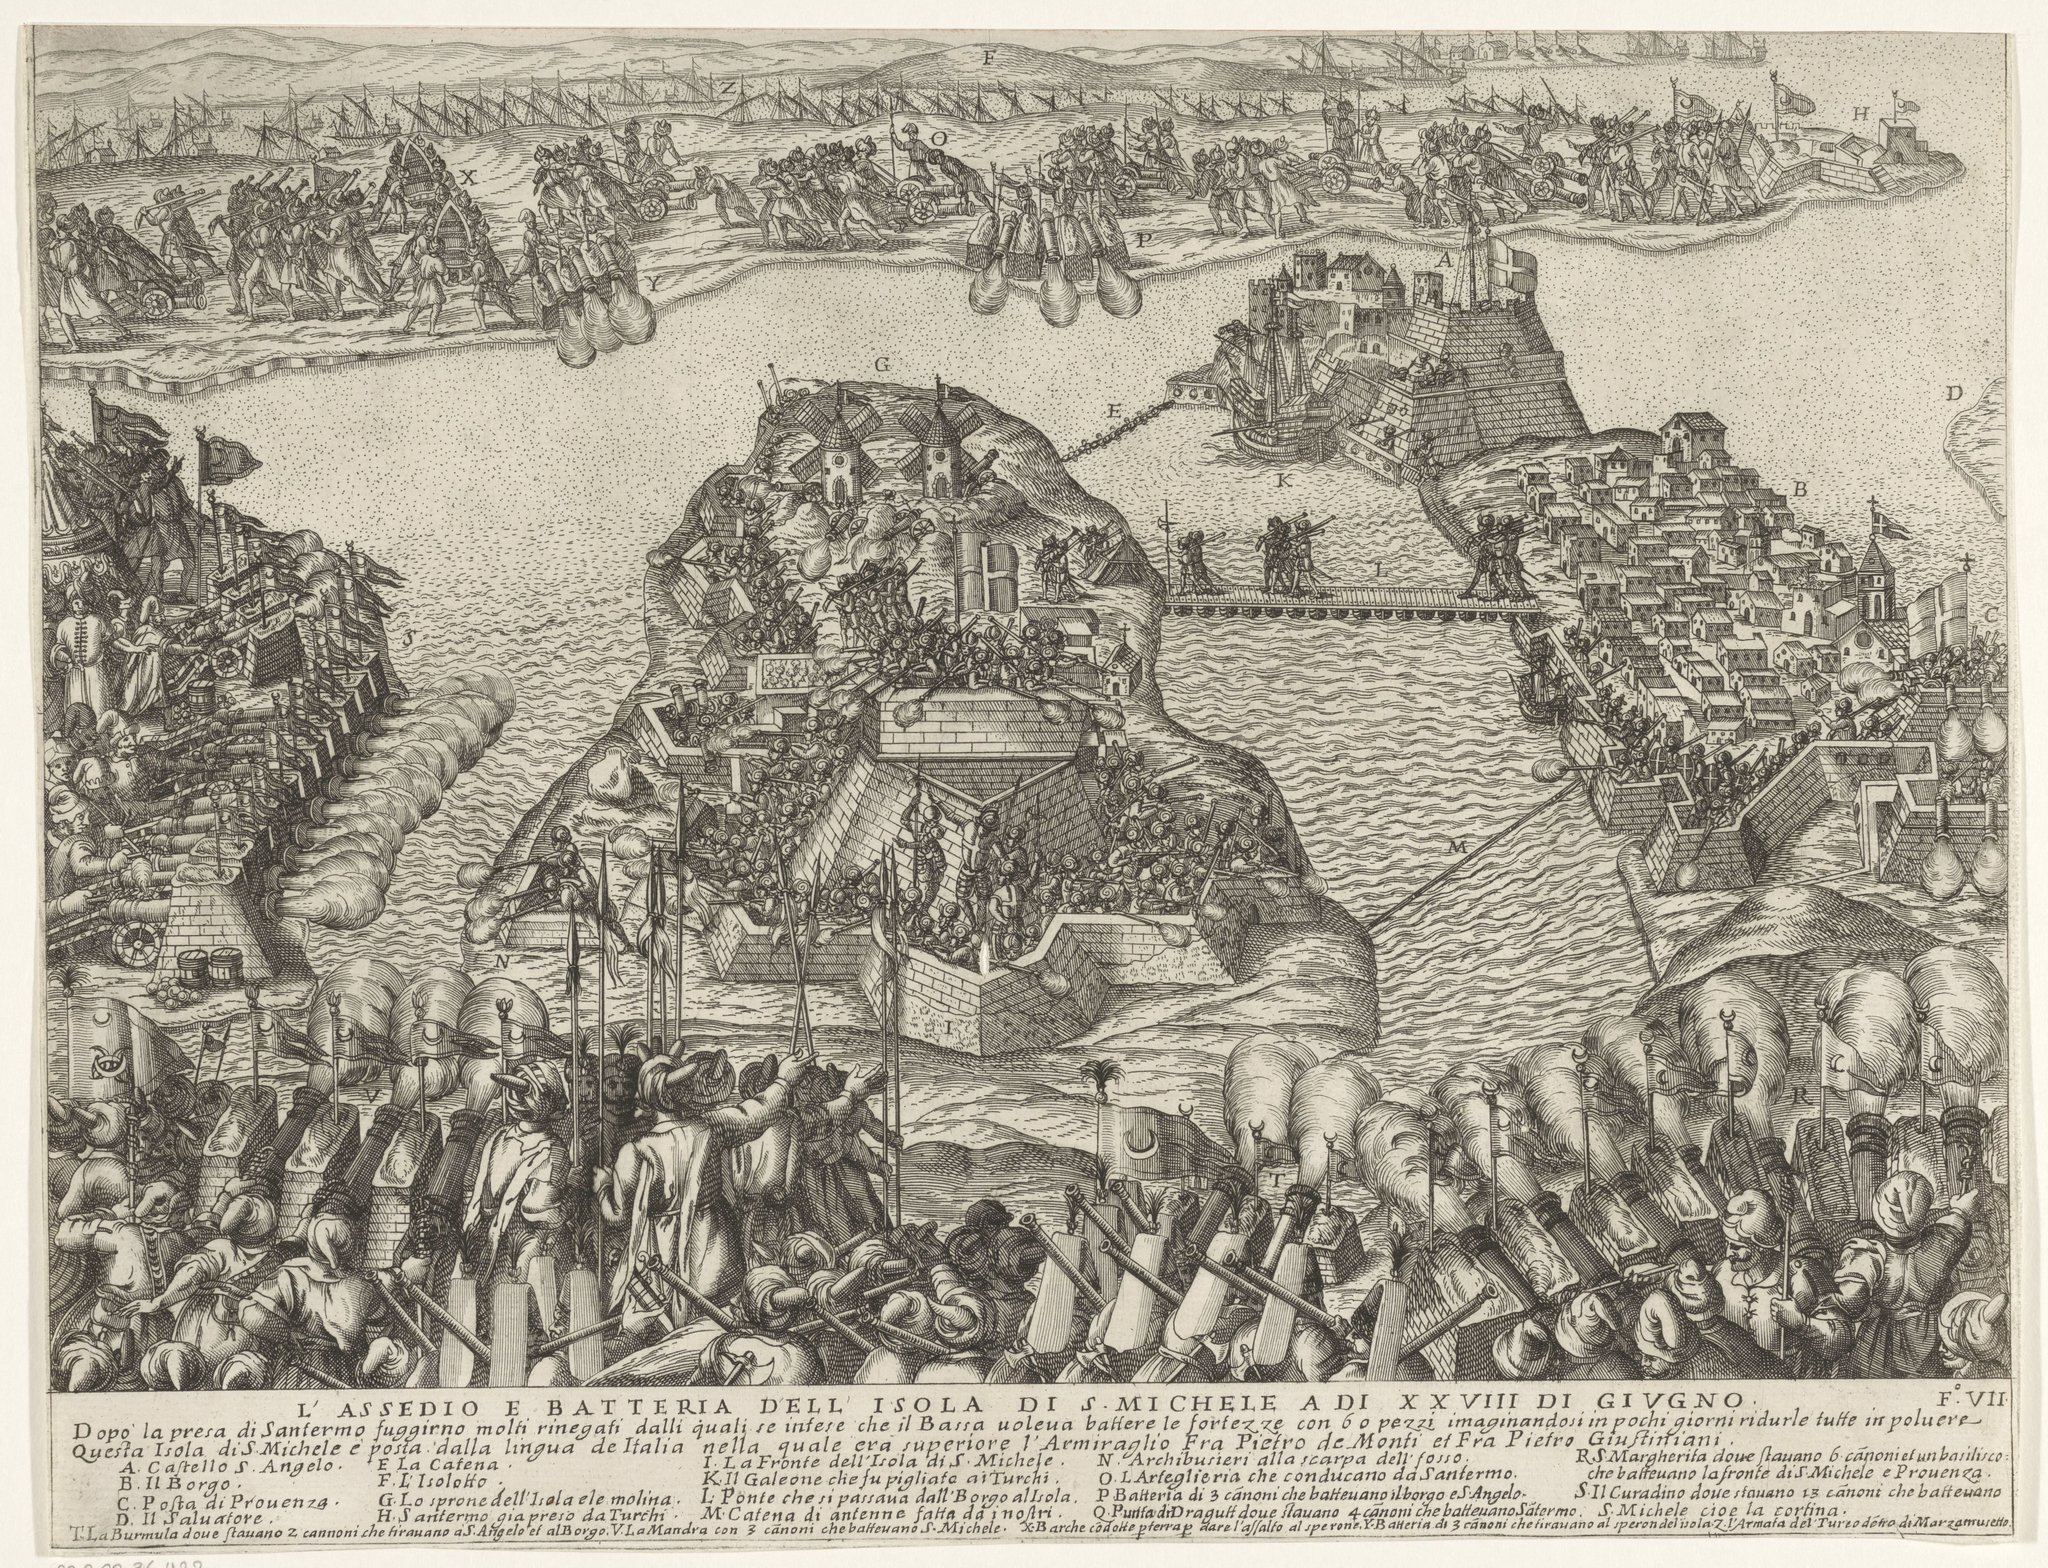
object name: print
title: Beleg van het eiland San Michele bij Malta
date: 1665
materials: paper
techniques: etching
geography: italy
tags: island, asiatic races and peoples: turks, battle (+ naval force), the soldier; the soldier's life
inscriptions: collector's mark: Lugt 2228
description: Beleg van het eiland San Michele bij Malta. Soldaten op het eiland San Michele proberen hun eiland te verdedigen tegen Turkse troepen. Italiaanse tekst en verklarende lijst met nummers in ondermarge. Genummerd rechtsonder: Fo. VII.